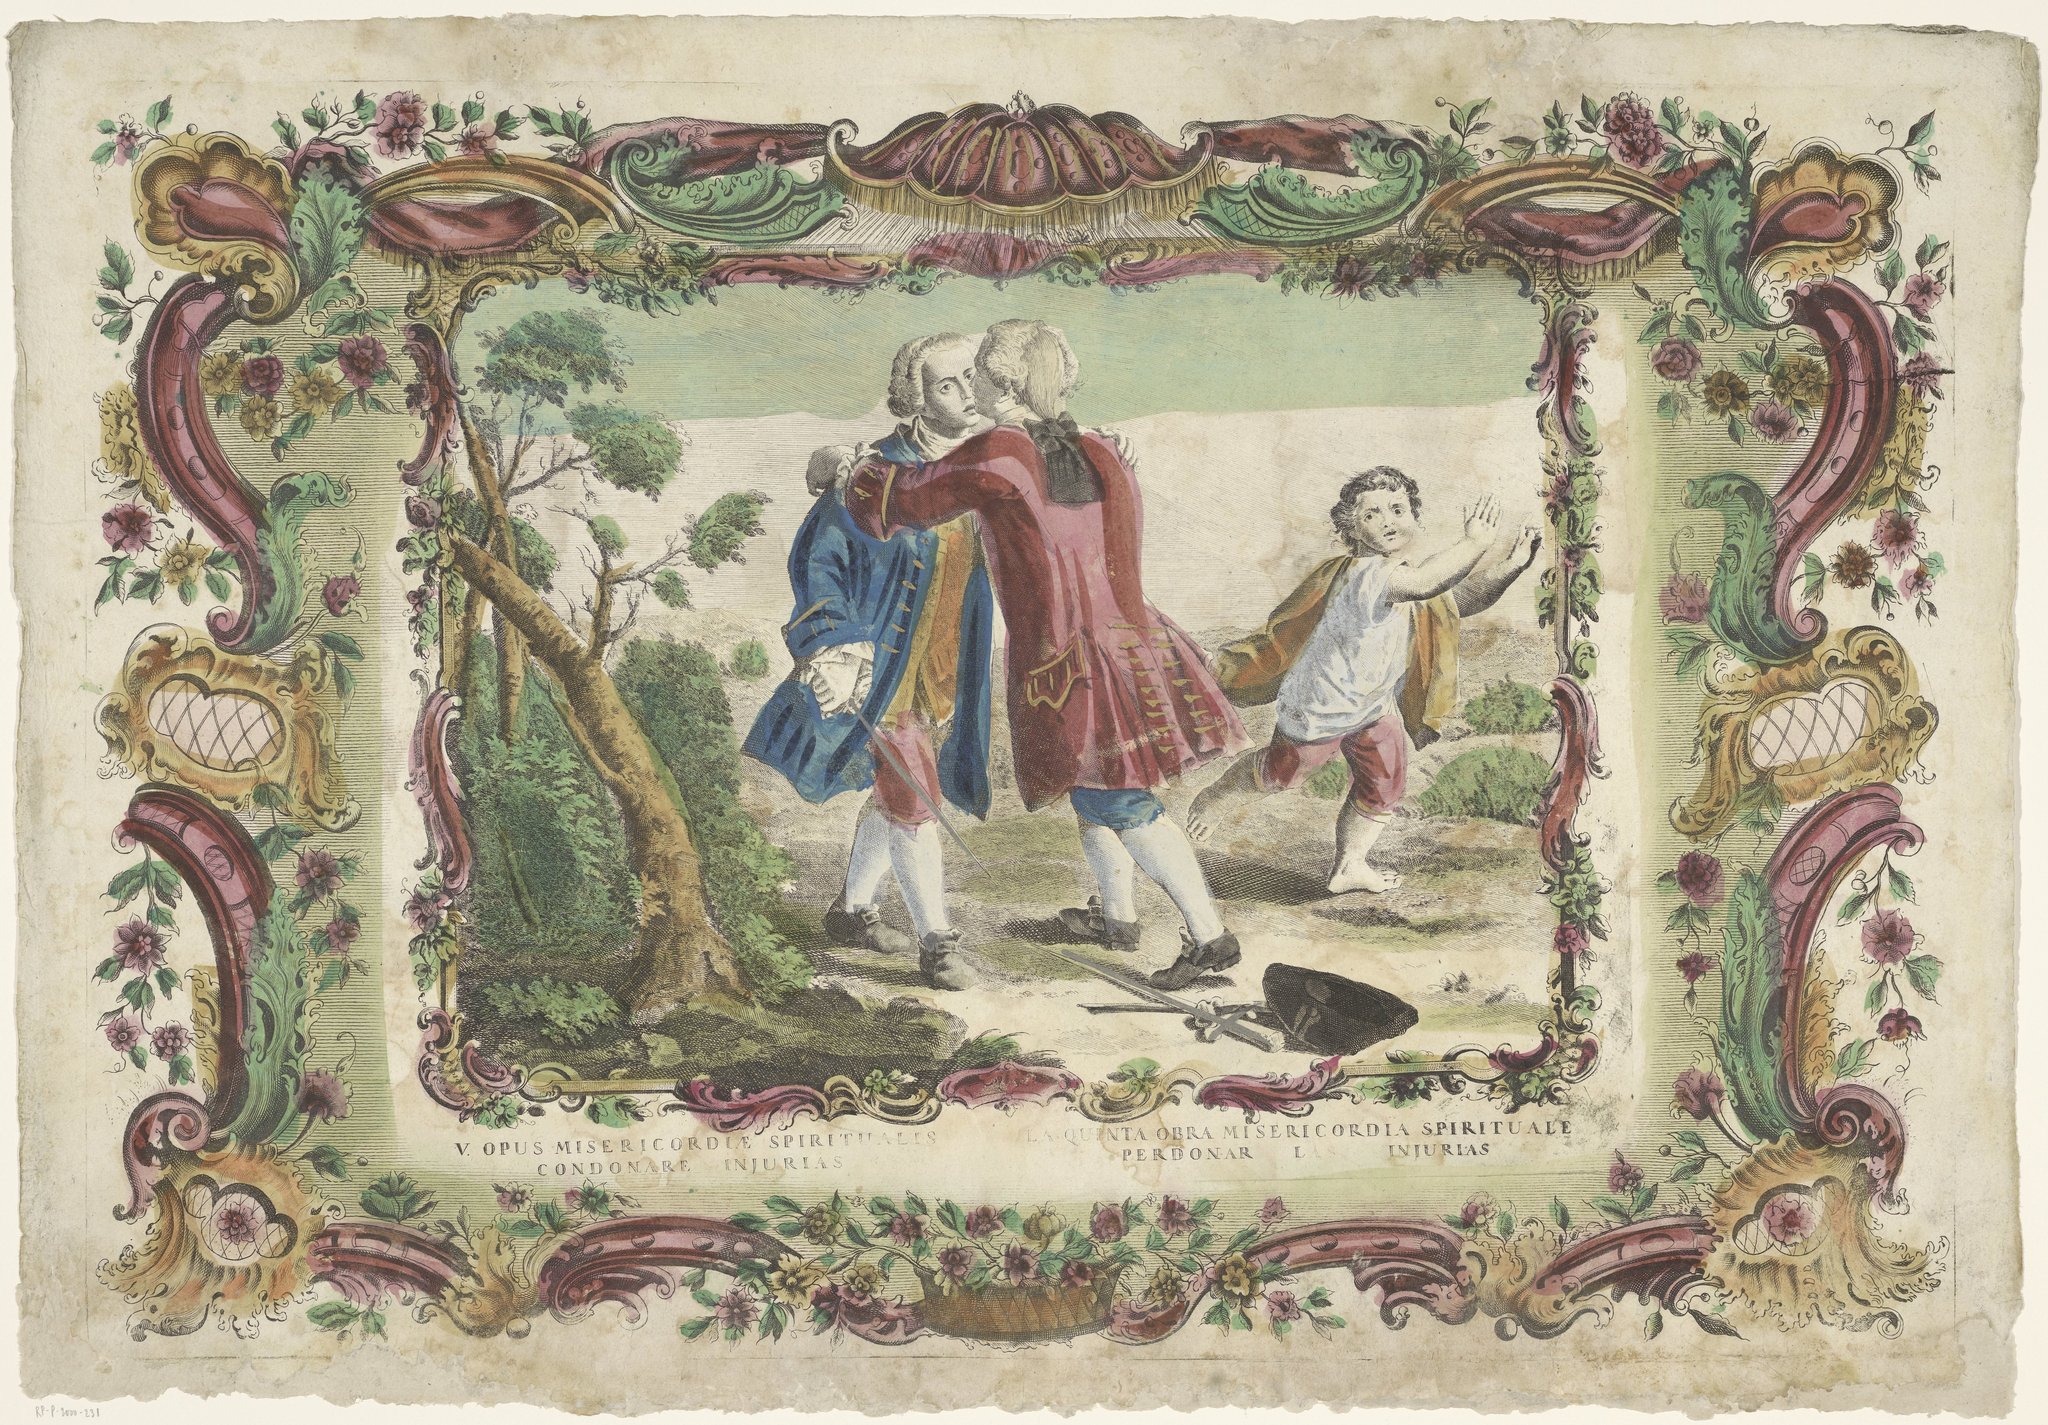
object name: print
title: Het vergeven van de zonden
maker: giovanni volpato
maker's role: ceramicist, print maker, printer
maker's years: 1735-1803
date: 1700-1799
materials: paper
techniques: colour, engraving, etching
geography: italy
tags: ornaments ~ art, forgiving injuries ~ one of the (seven) spiritual acts of mercy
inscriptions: collector's mark: Lugt 2760, collector's mark: Lugt 2228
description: Uitbeelding van één van de spirituele werken van barmhartigheid: het vergeven van de zonden. Twee mannen omhelzen elkaar in een landschap. De een houdt een degen in de hand. De degen van de ander ligt op de grond. Een jongen vlucht weg. Titel onder de voorstelling. De scène is gevat in een ornamentrand.